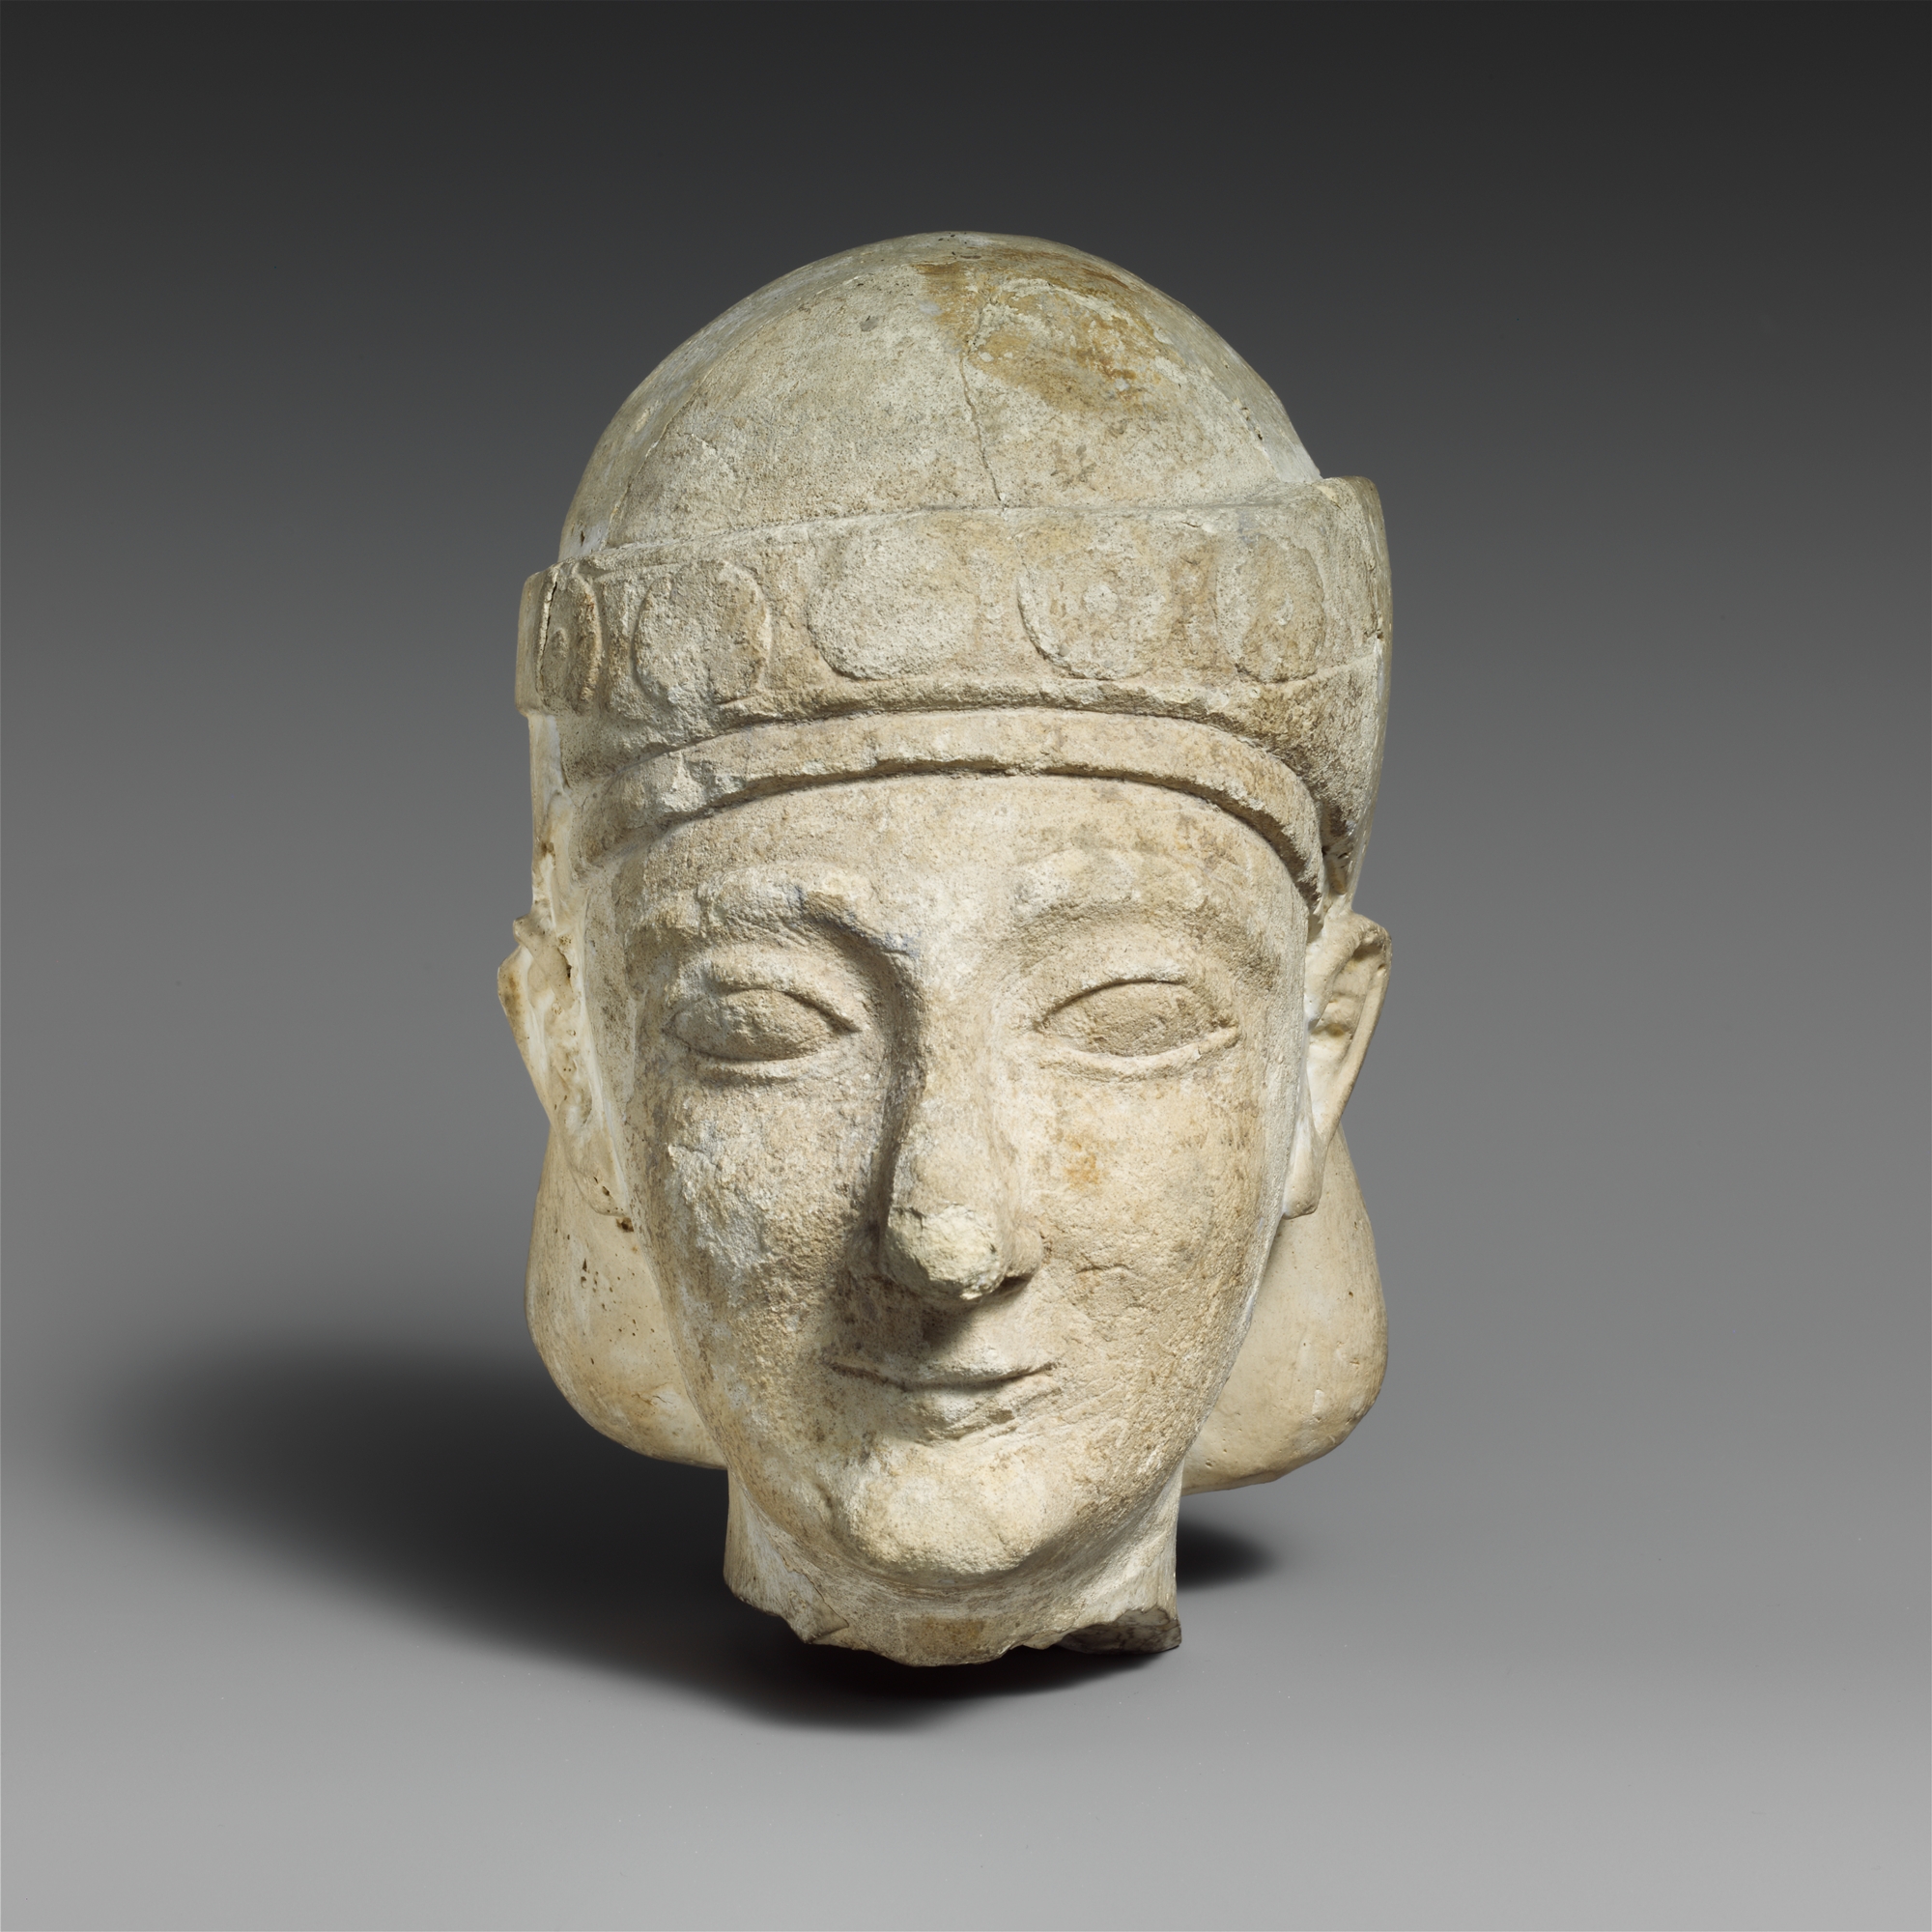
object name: head of a youth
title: Limestone head of a beardless male with a diadem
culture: cypriot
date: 575-551 BCE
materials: limestone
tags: diadems,heads,men